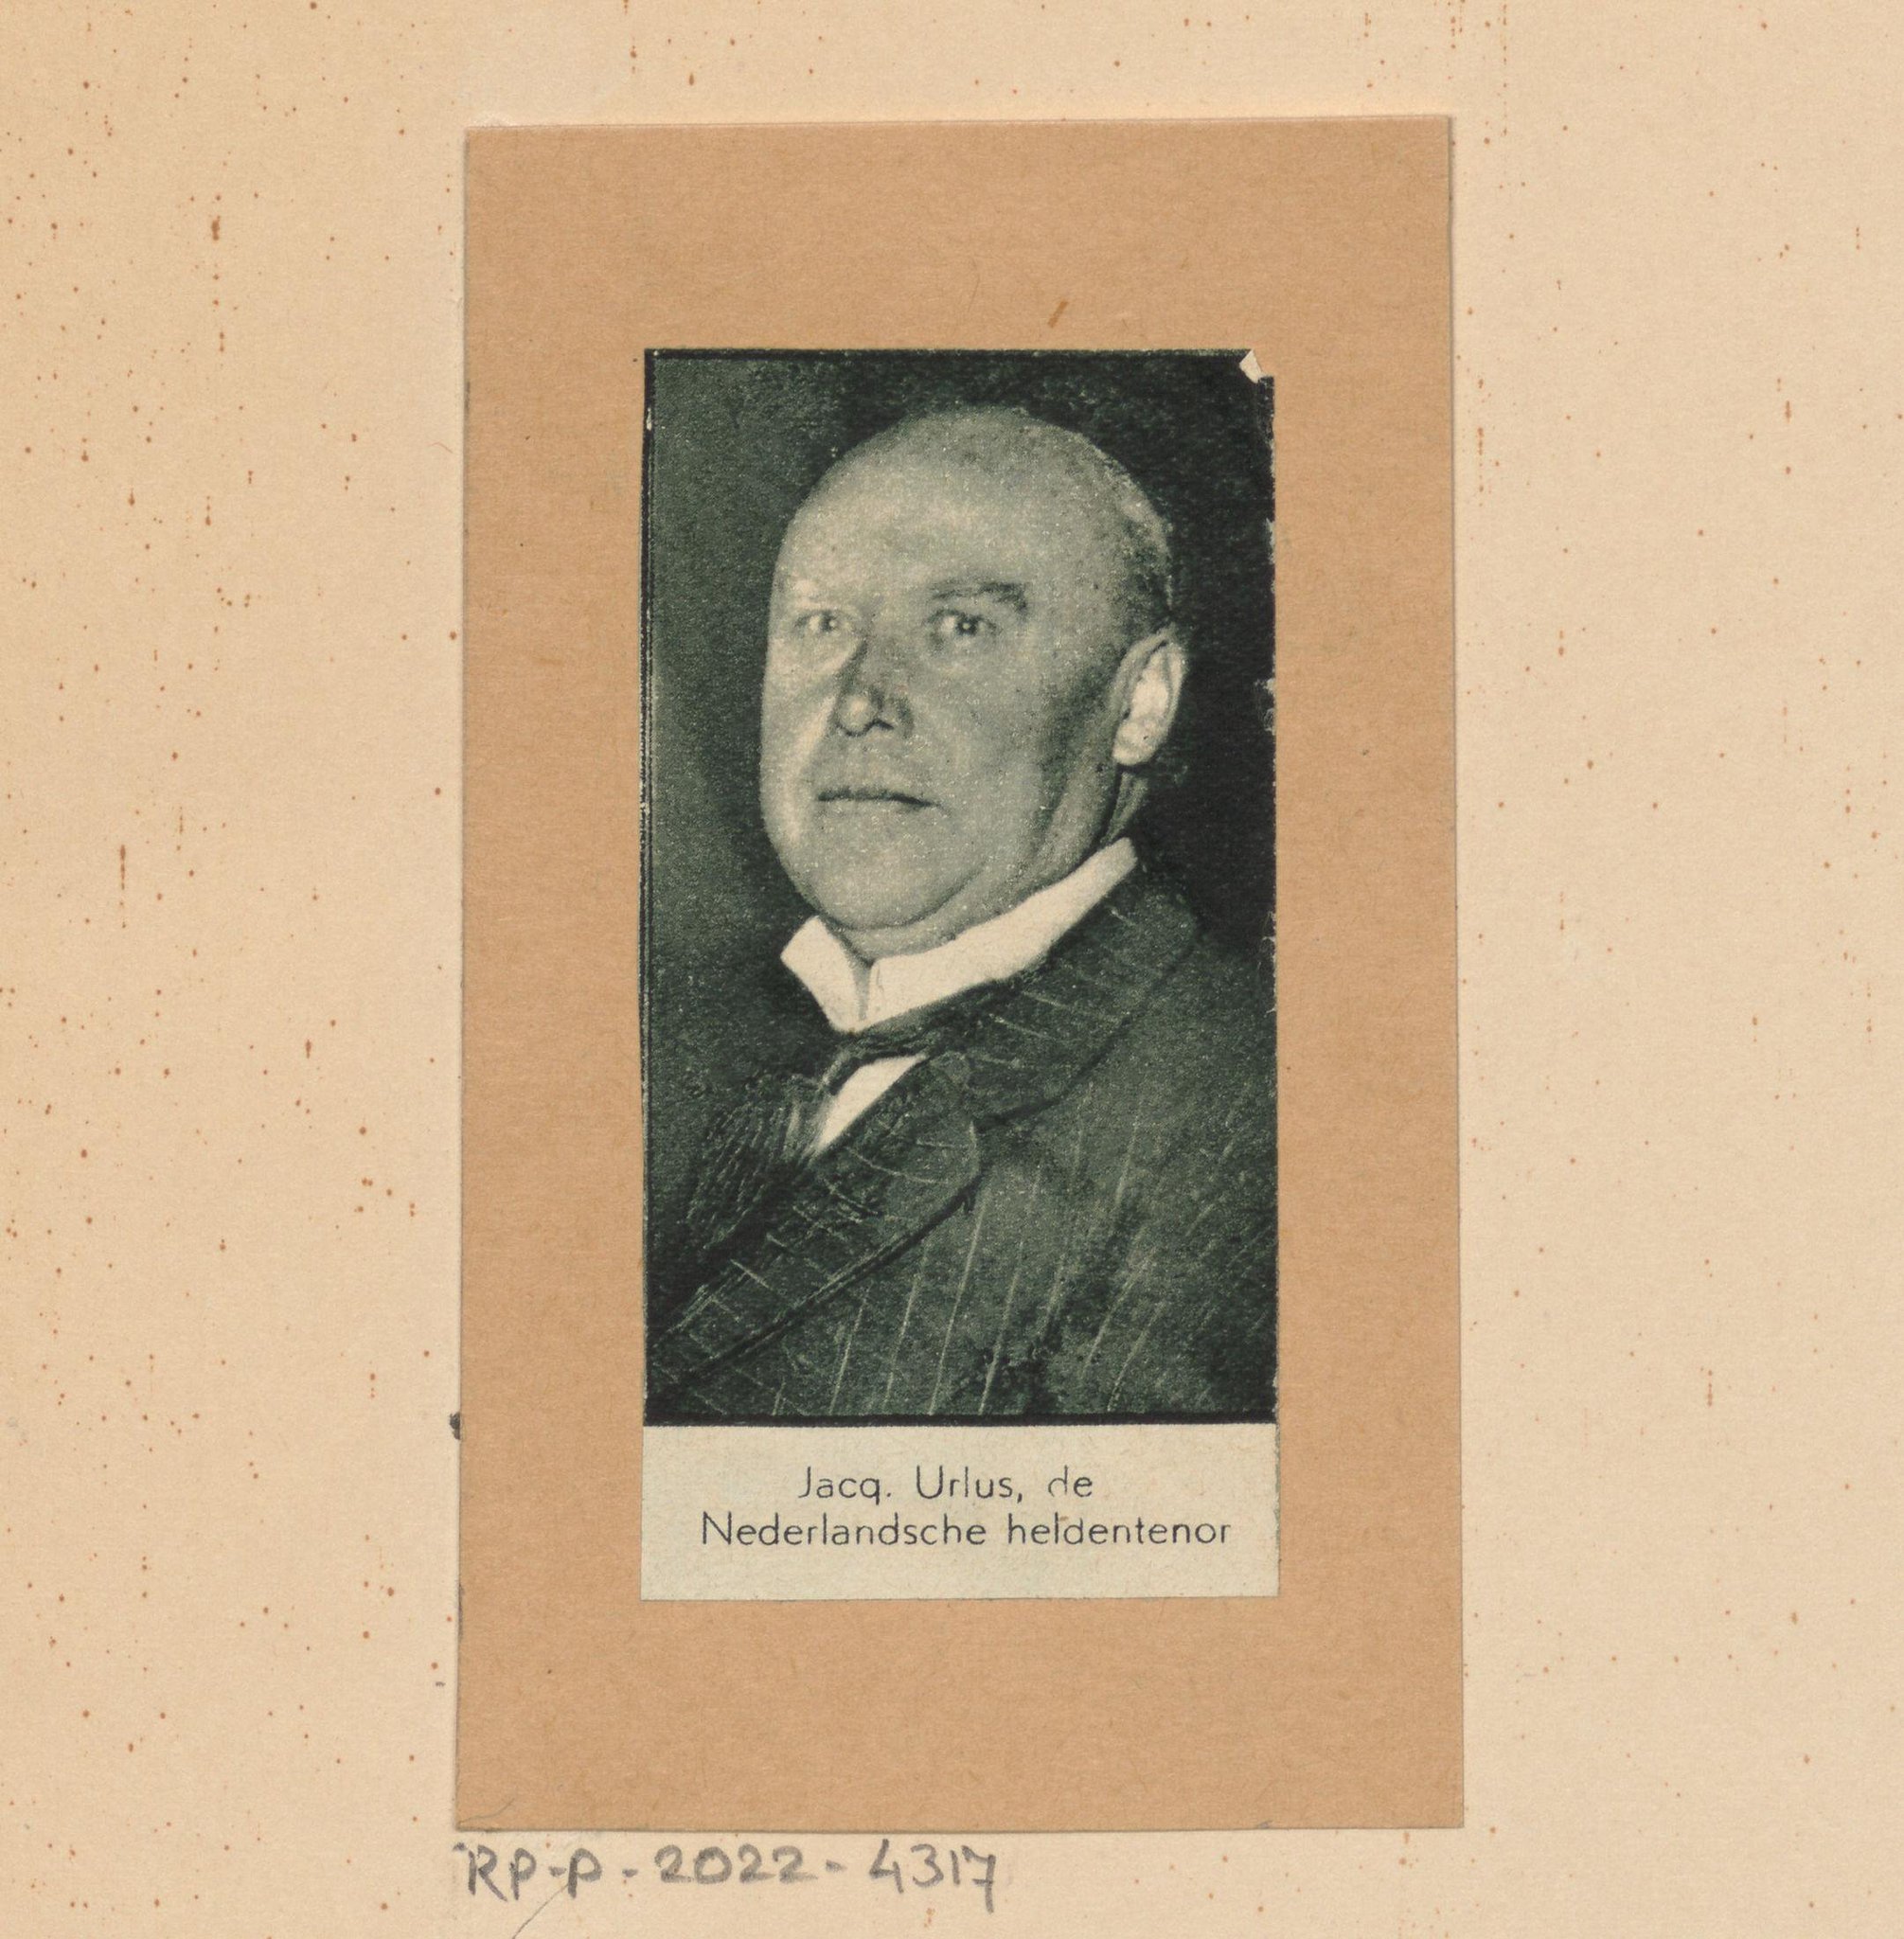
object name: photomechanical print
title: Portret van Jacques Urlus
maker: Anonymous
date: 1900-1915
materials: paper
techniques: photoaquatint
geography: netherlands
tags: historical persons, portrait of opera-singer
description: Prent komt uit een onbekende publicatie.